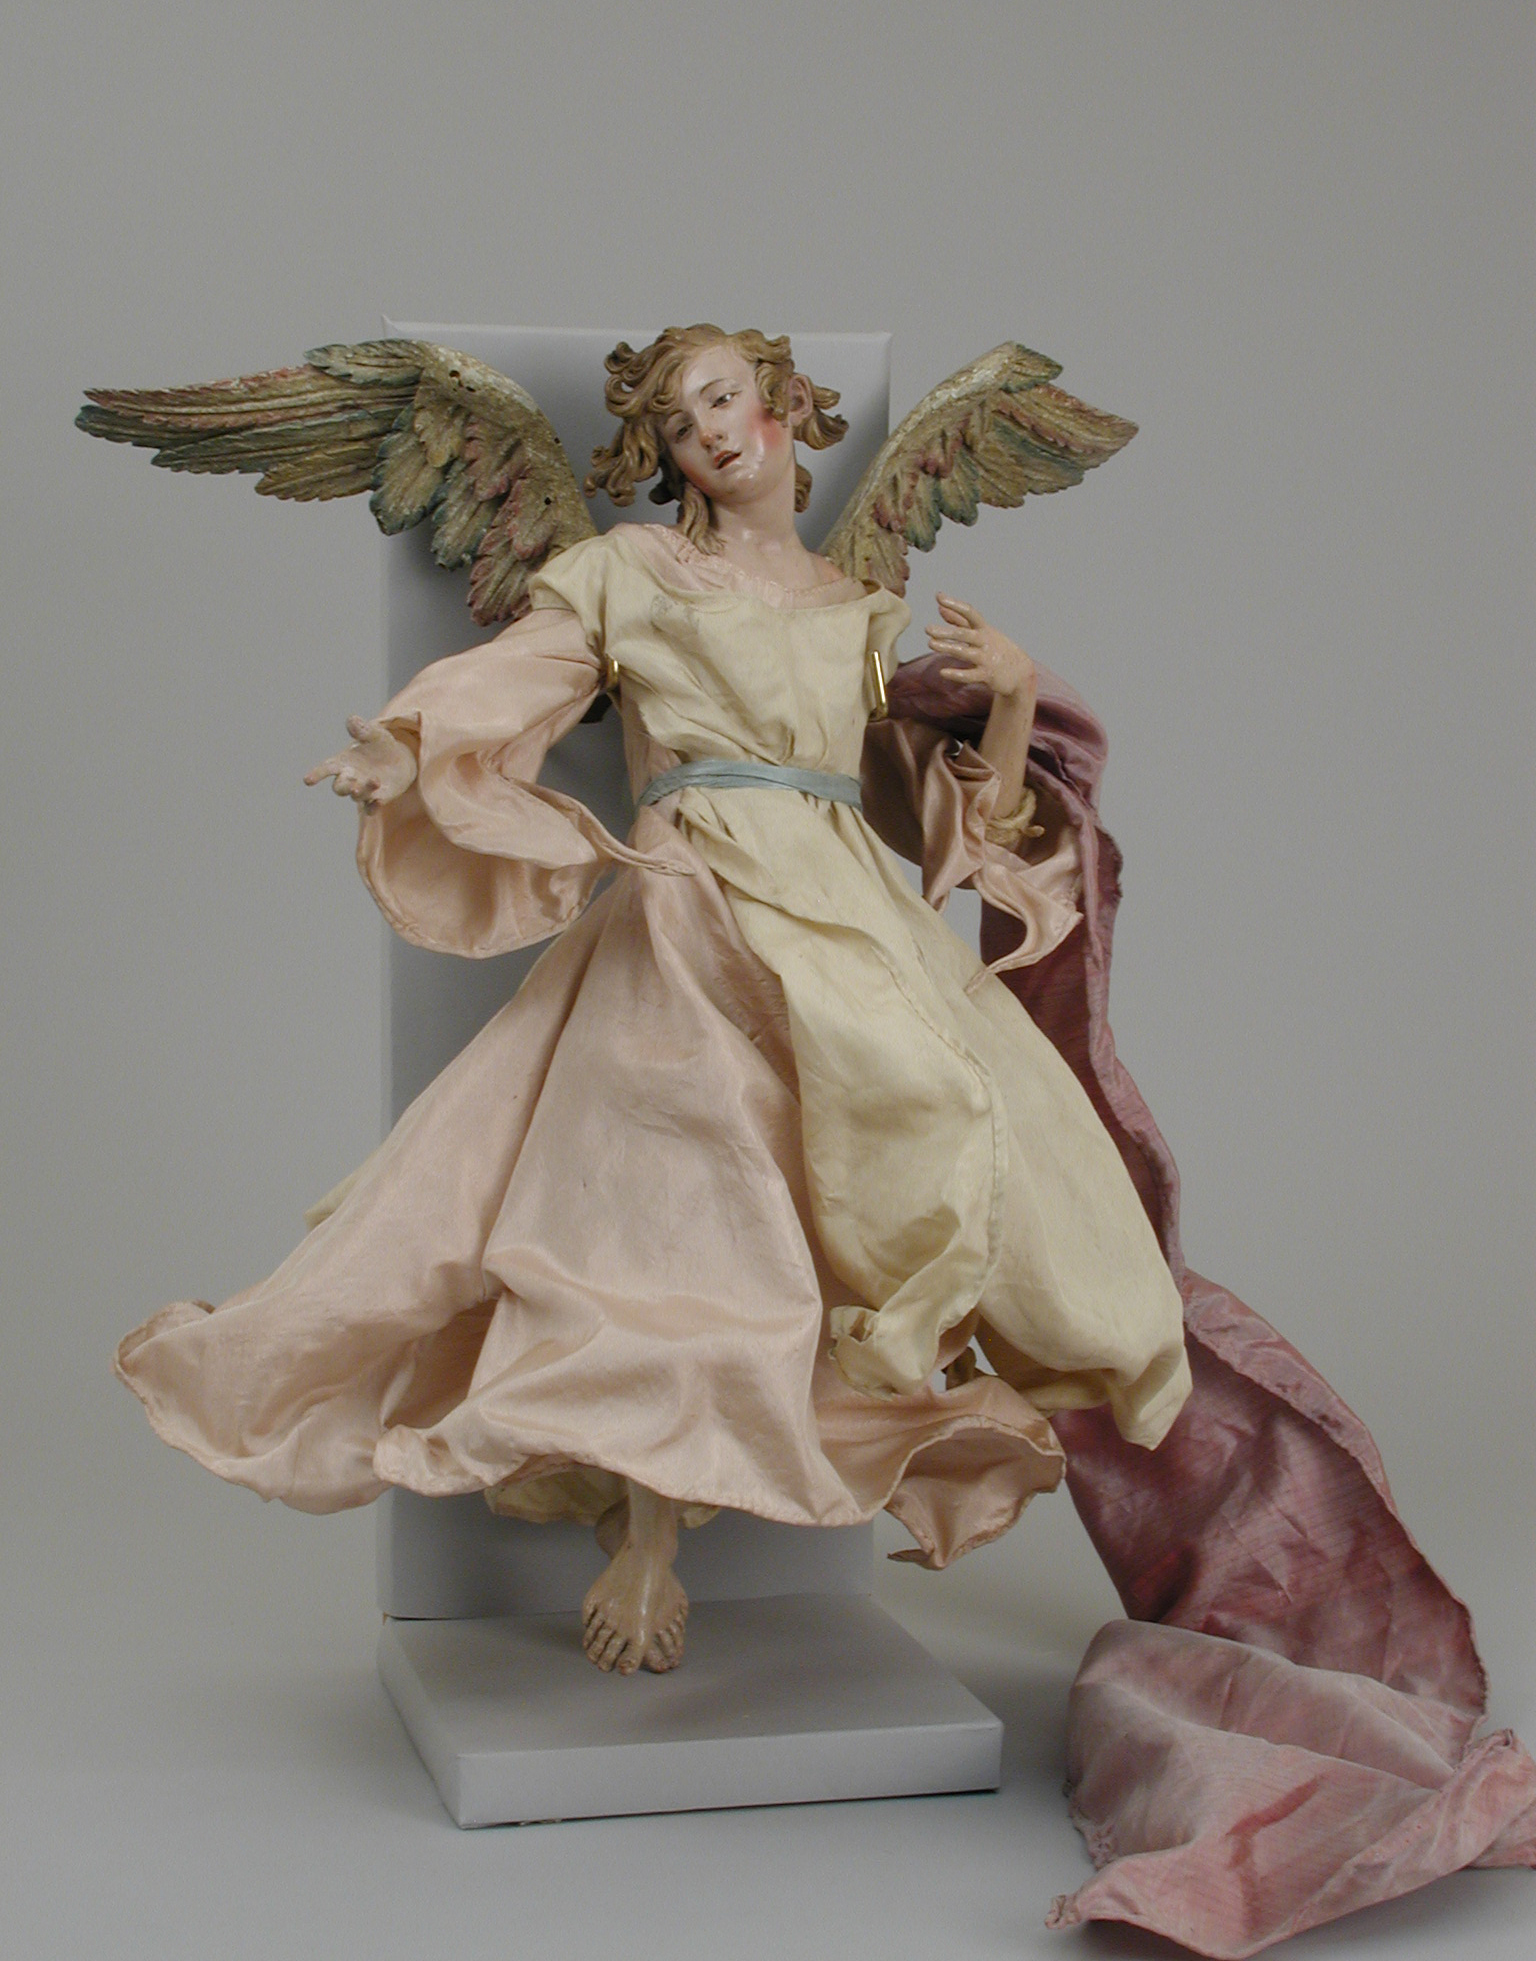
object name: crèche figure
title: Angel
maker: giuseppe sanmartino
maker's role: maker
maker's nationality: italian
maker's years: 1720-1793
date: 1751-1800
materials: terracotta, fiber, metal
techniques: polychrome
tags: angels